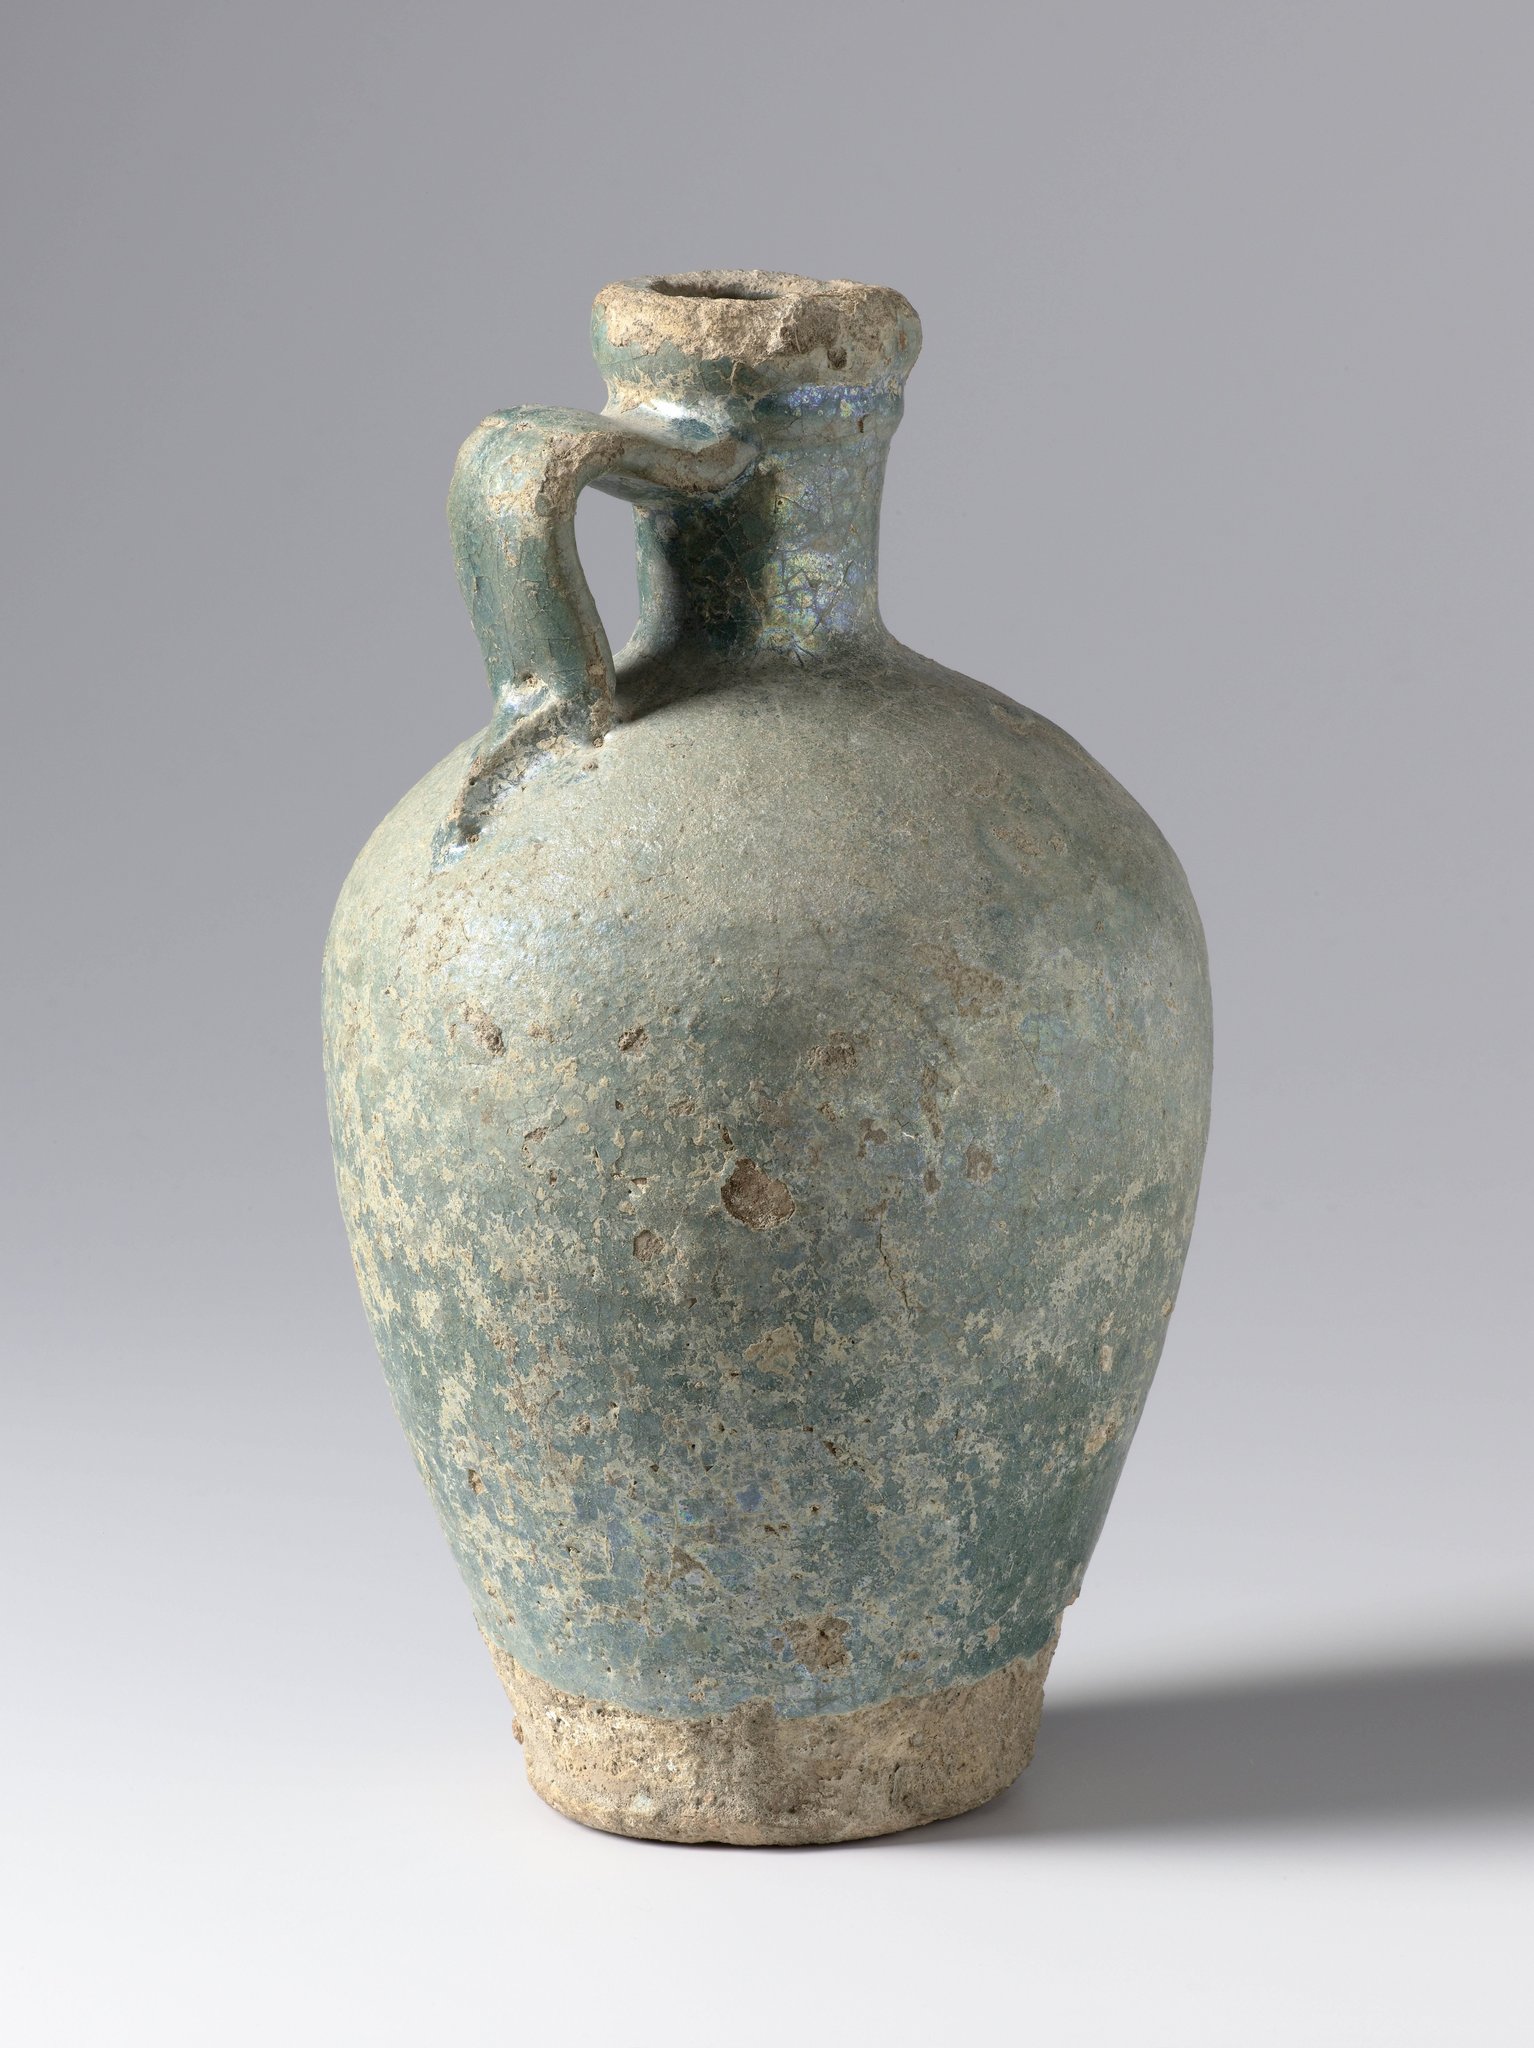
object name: jug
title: Ovoid vessel with a turquoise glaze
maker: Anonymous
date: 1175-1224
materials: earthenware, glaze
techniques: firing, turning, vitrification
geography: afghanistan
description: Eivormige kruik van aardewerk bedekt met een monochroom turquoise loodglazuur.